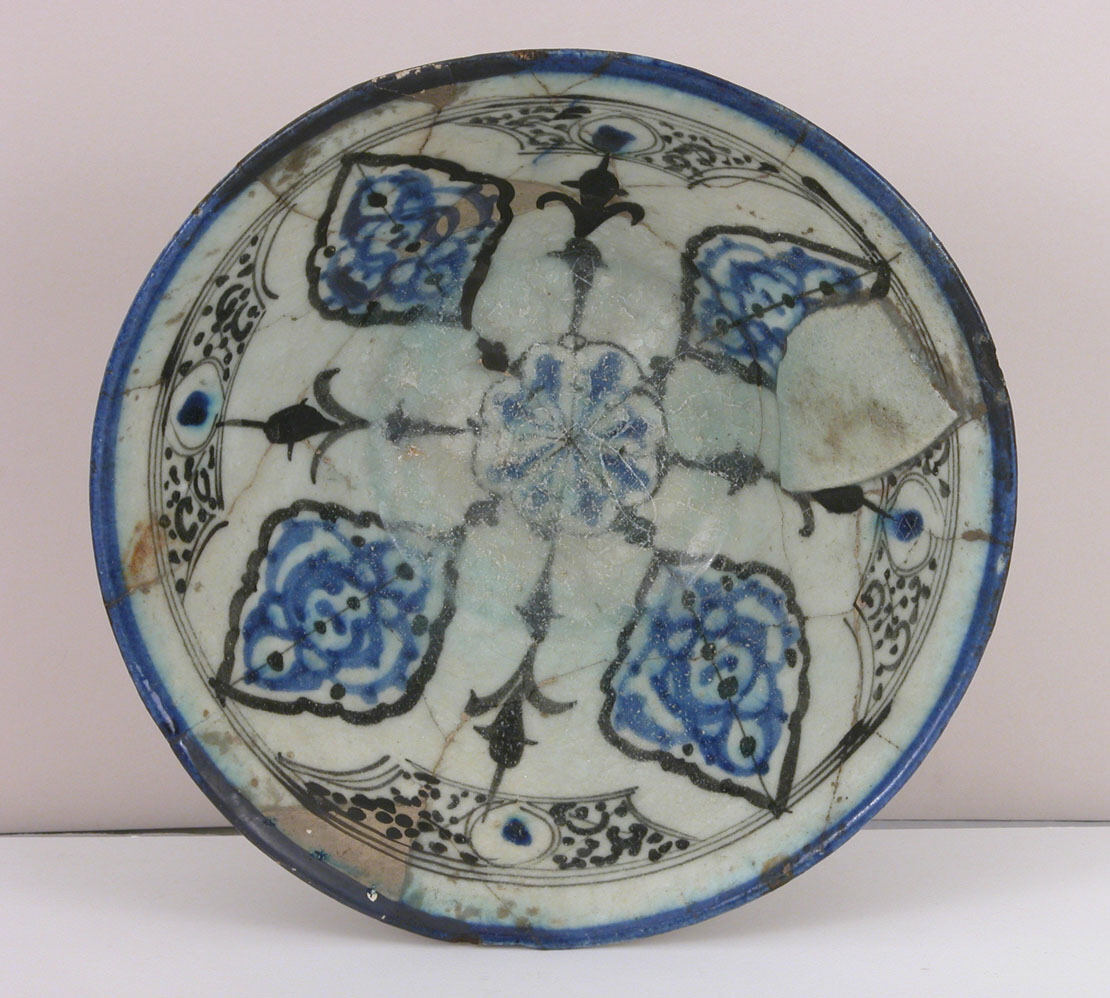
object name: bowl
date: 1201-1300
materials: glaze, stonepaste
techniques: painting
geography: syria